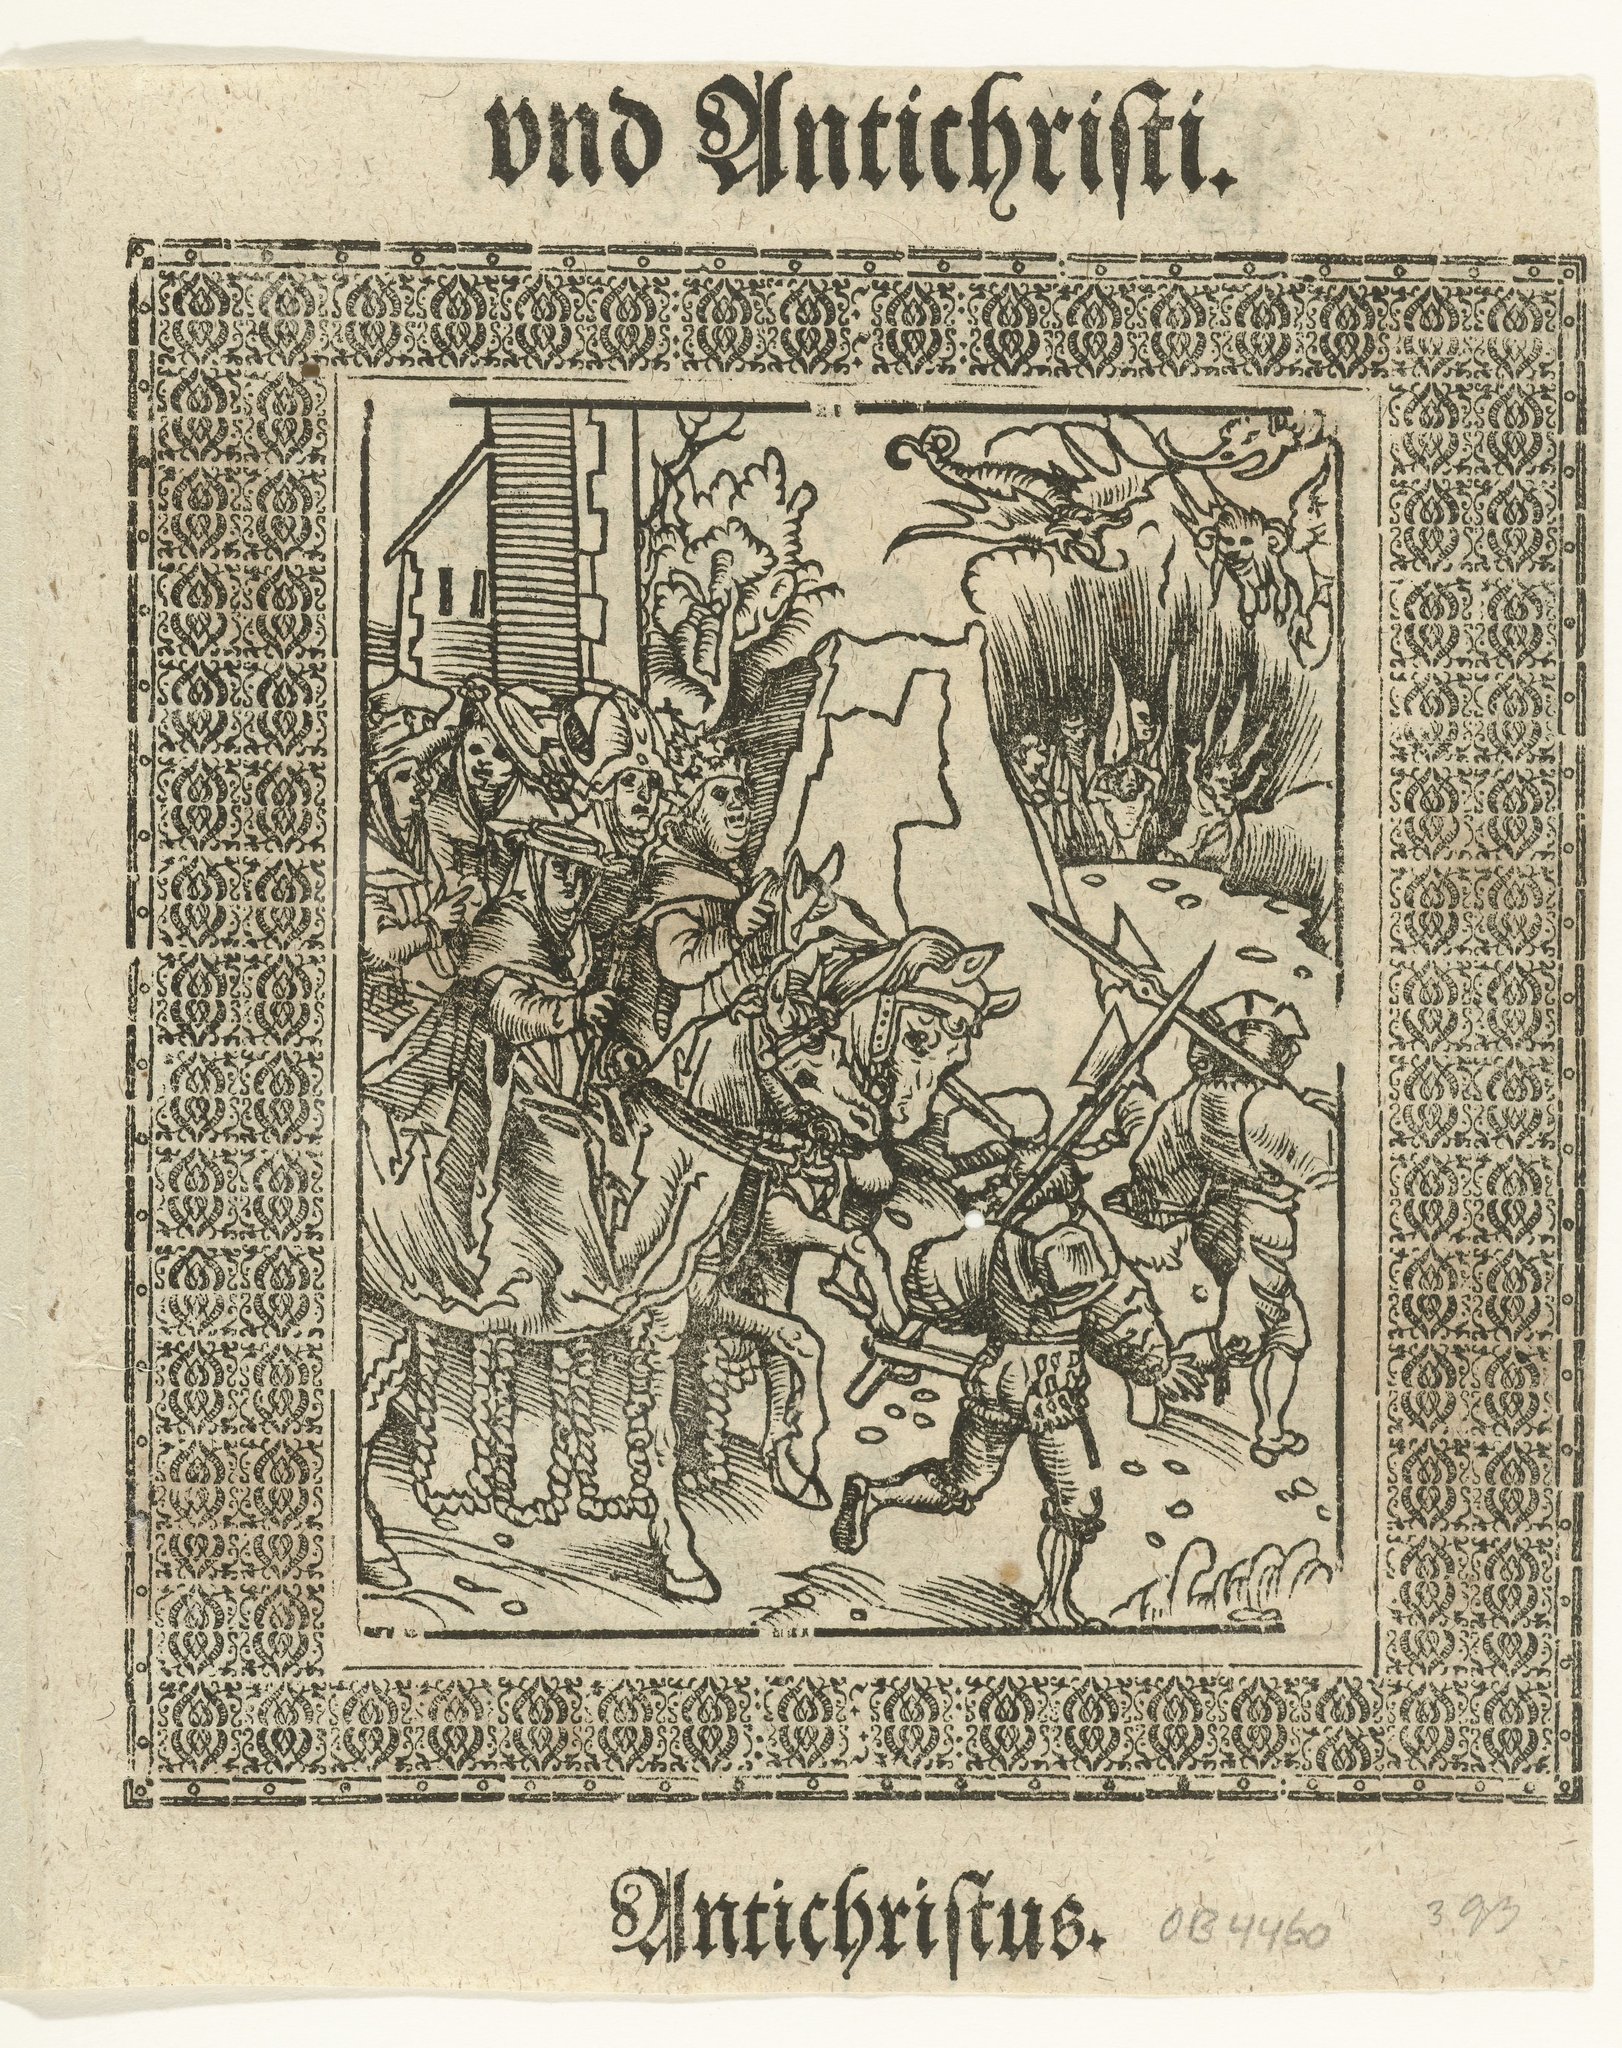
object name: print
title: Paus en zijn gevolg te paard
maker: lucas cranach (i)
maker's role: draughtsman, print maker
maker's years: 1472-1553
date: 1521-1522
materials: paper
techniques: woodcut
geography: wittenberg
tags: pope, organization, functionaries and dignitaries in roman catholic church; clergy in general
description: De tegenhanger van deze prent is de voorstelling Intocht van Christus in Jerusalem, zie RP-P-OB-4459(R). Blad uit: Passional Christi und Antichristi, Wittenberg 1521-1522, Johann Grünenberg. In 1521-1522 verschenen veel verschillende uitgaven van dit populaire werk van Maarten Luther. In de collectie van het RMA bevindt zich de complete serie van zesentwintig afbeeldingen uit een van deze uitgaven. De pagina's zijn op een kleiner formaat gesneden, onder iedere voorstelling stond oorspronkelijk een aantal regels Duitse tekst. De bladen hebben allemaal op dezelfde plaats twee kleine gaatjes van vraat door ongedierte wat er op wijst dat ze behoren tot hetzelfde exemplaar.